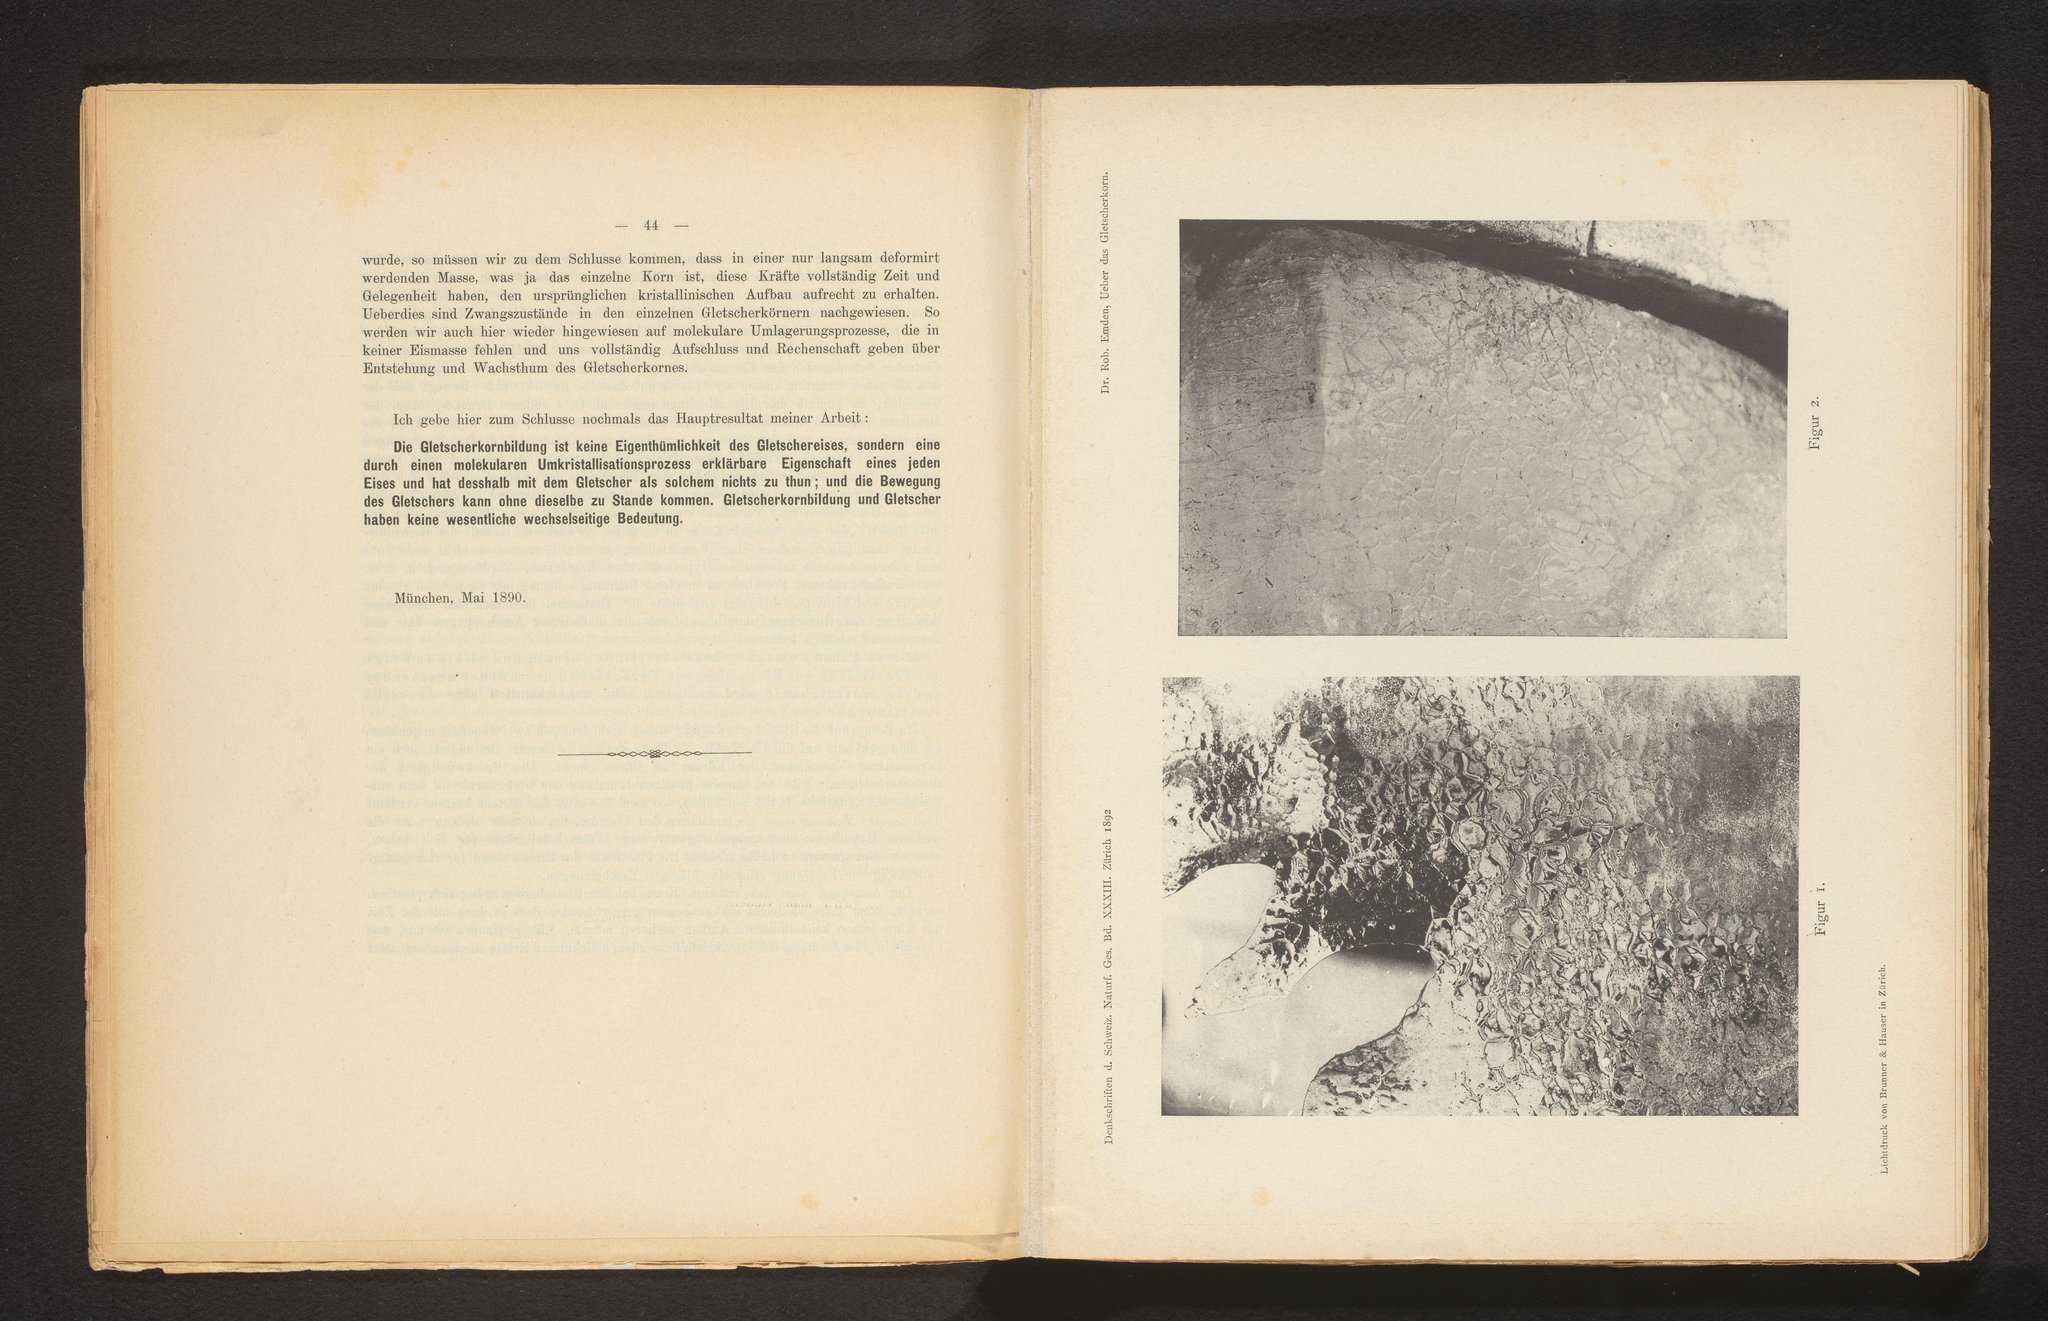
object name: photomechanical print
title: Gletsjerijs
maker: Anonymous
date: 1883-1893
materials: paper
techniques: photograph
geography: zurich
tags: glacier, ice ~ state of water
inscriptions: number: ‘Figur 1. Figur 2.’